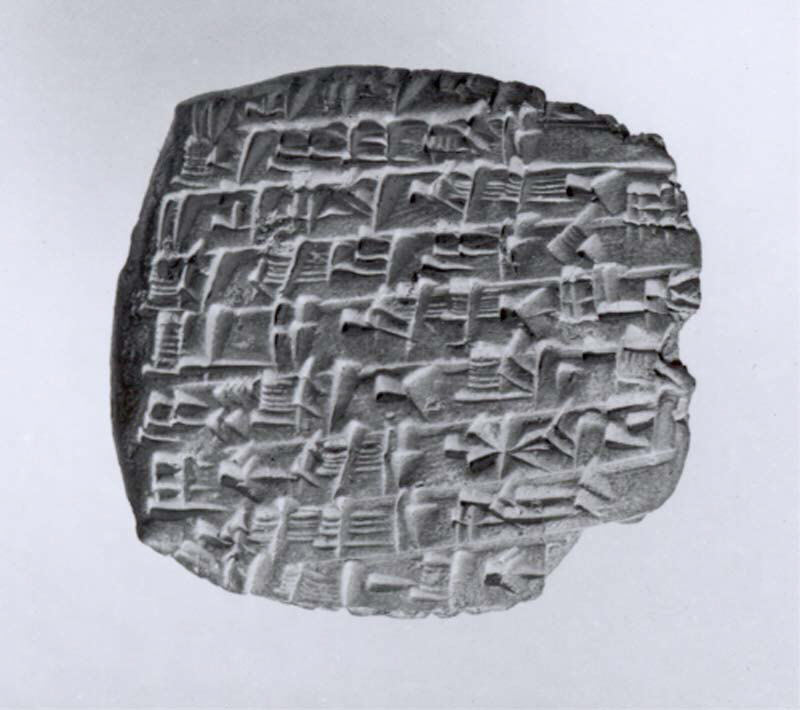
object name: cuneiform tablet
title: Cuneiform tablet: private letter fragment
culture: assyrian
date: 2000-1801 BCE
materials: clay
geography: anatolia